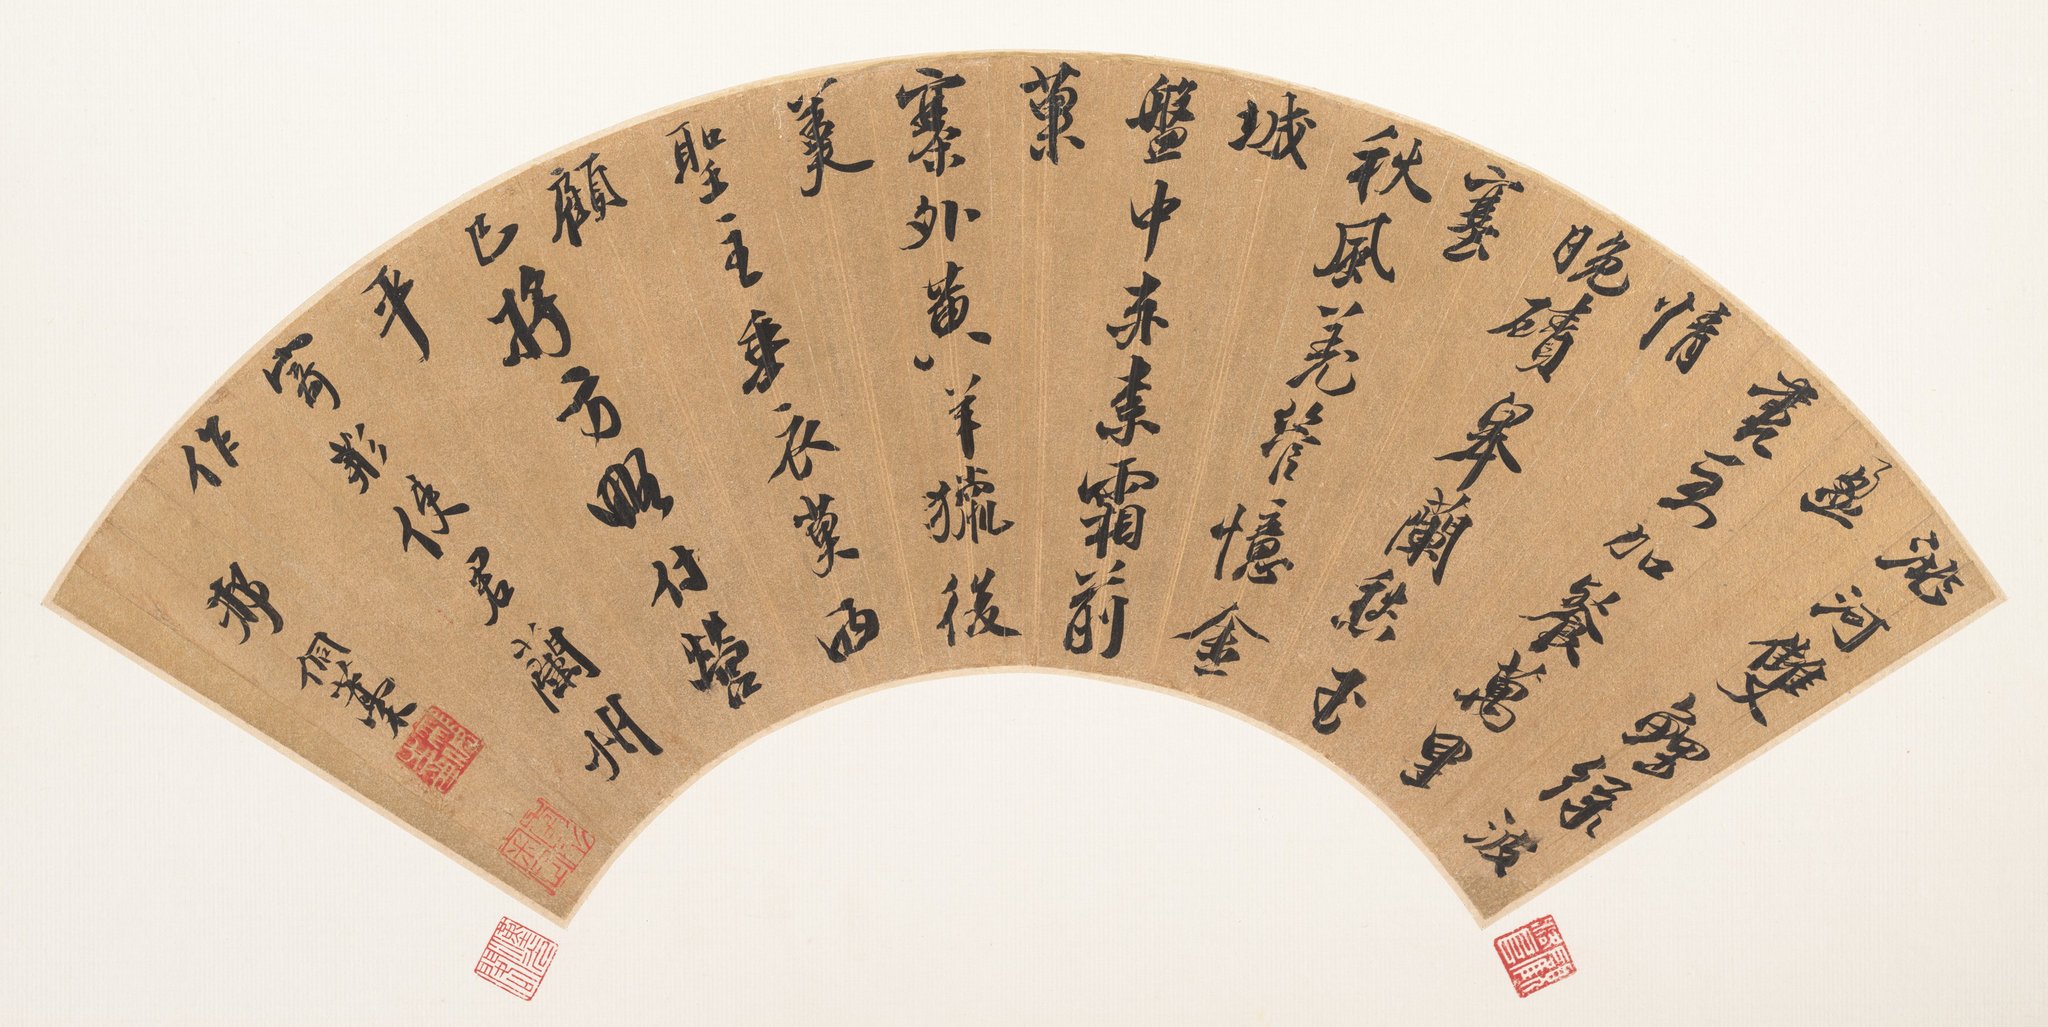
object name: folding fan mounted a an album leaf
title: Poem on Lanzhou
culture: chinese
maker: xing tong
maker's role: artist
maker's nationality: chinese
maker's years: 1551-1612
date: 1551-1612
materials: gold, ink, paper